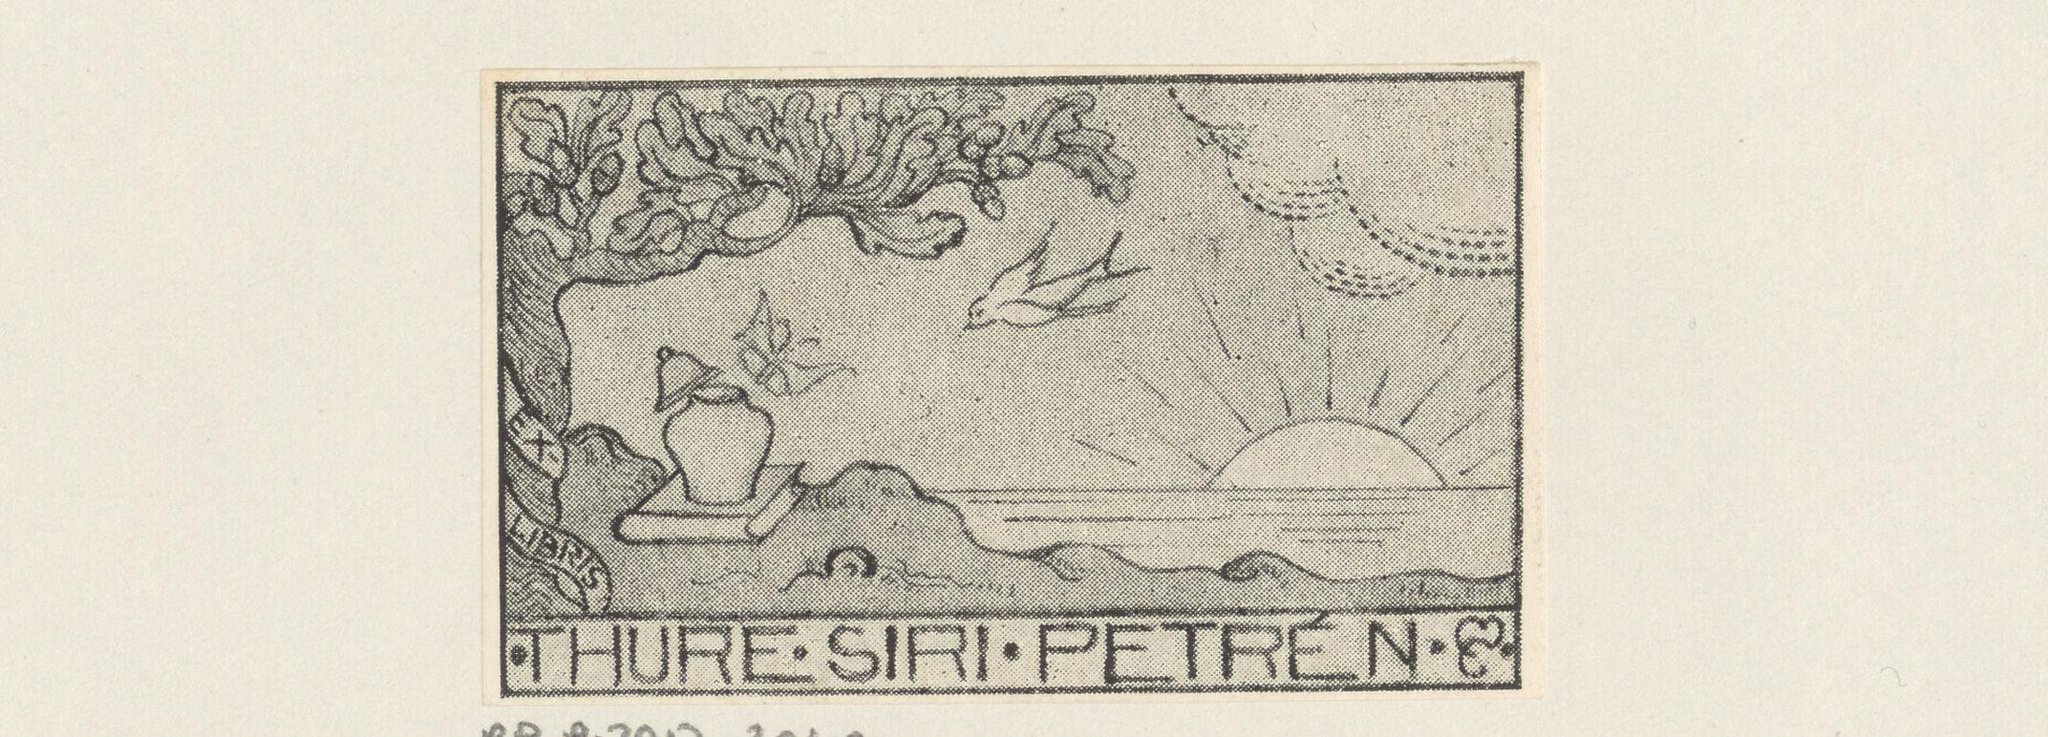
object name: photomechanical print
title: Ex libris van Thure en Siri Petrén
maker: Anonymous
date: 1900-1938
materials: paper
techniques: autotype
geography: sweden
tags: trees: oak, song-birds: swallow, book, urn, sunset, sea